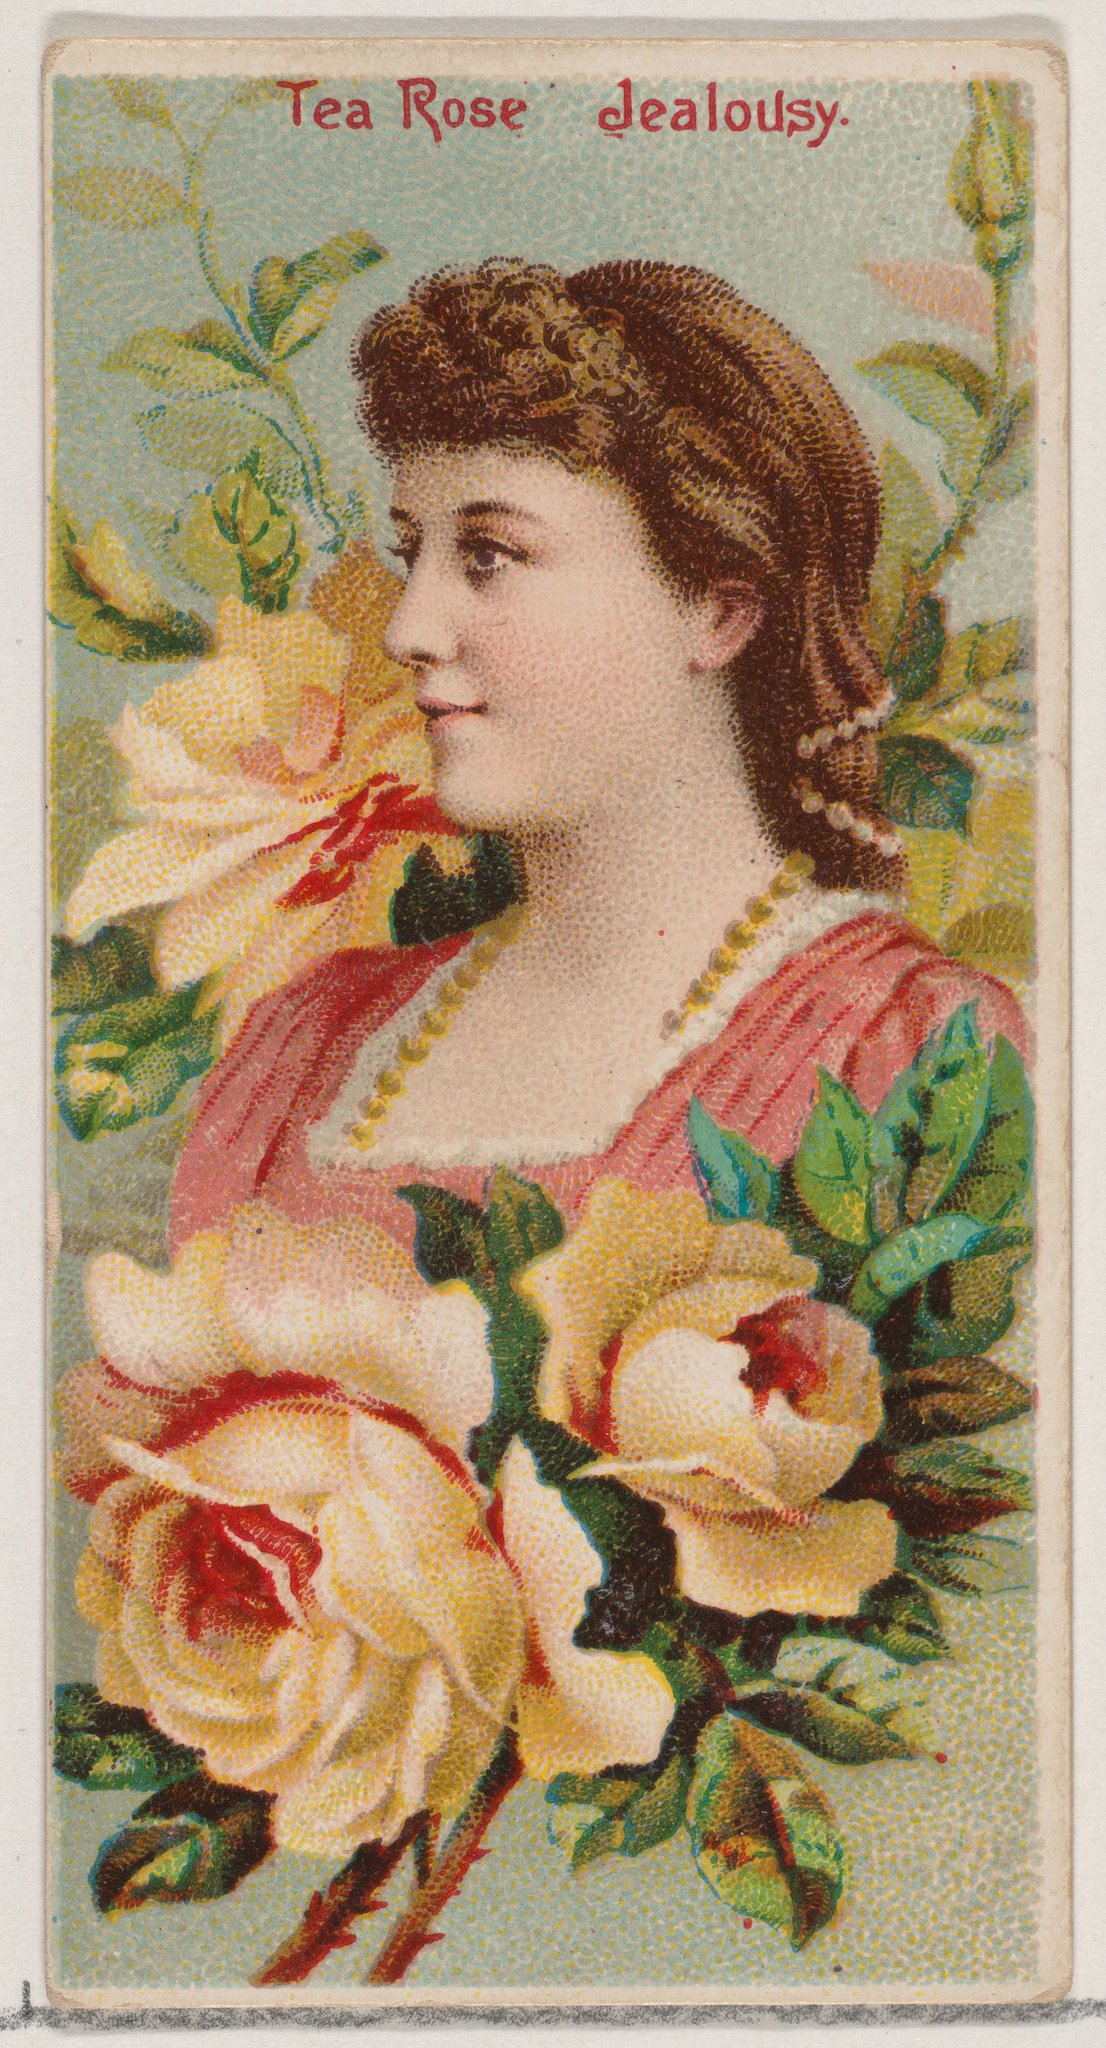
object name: print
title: Tea Rose: Jealousy, from the series Floral Beauties and Language of Flowers (N75) for Duke brand cigarettes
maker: american tobacco company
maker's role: publisher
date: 1892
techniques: color lithograph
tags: women,flowers